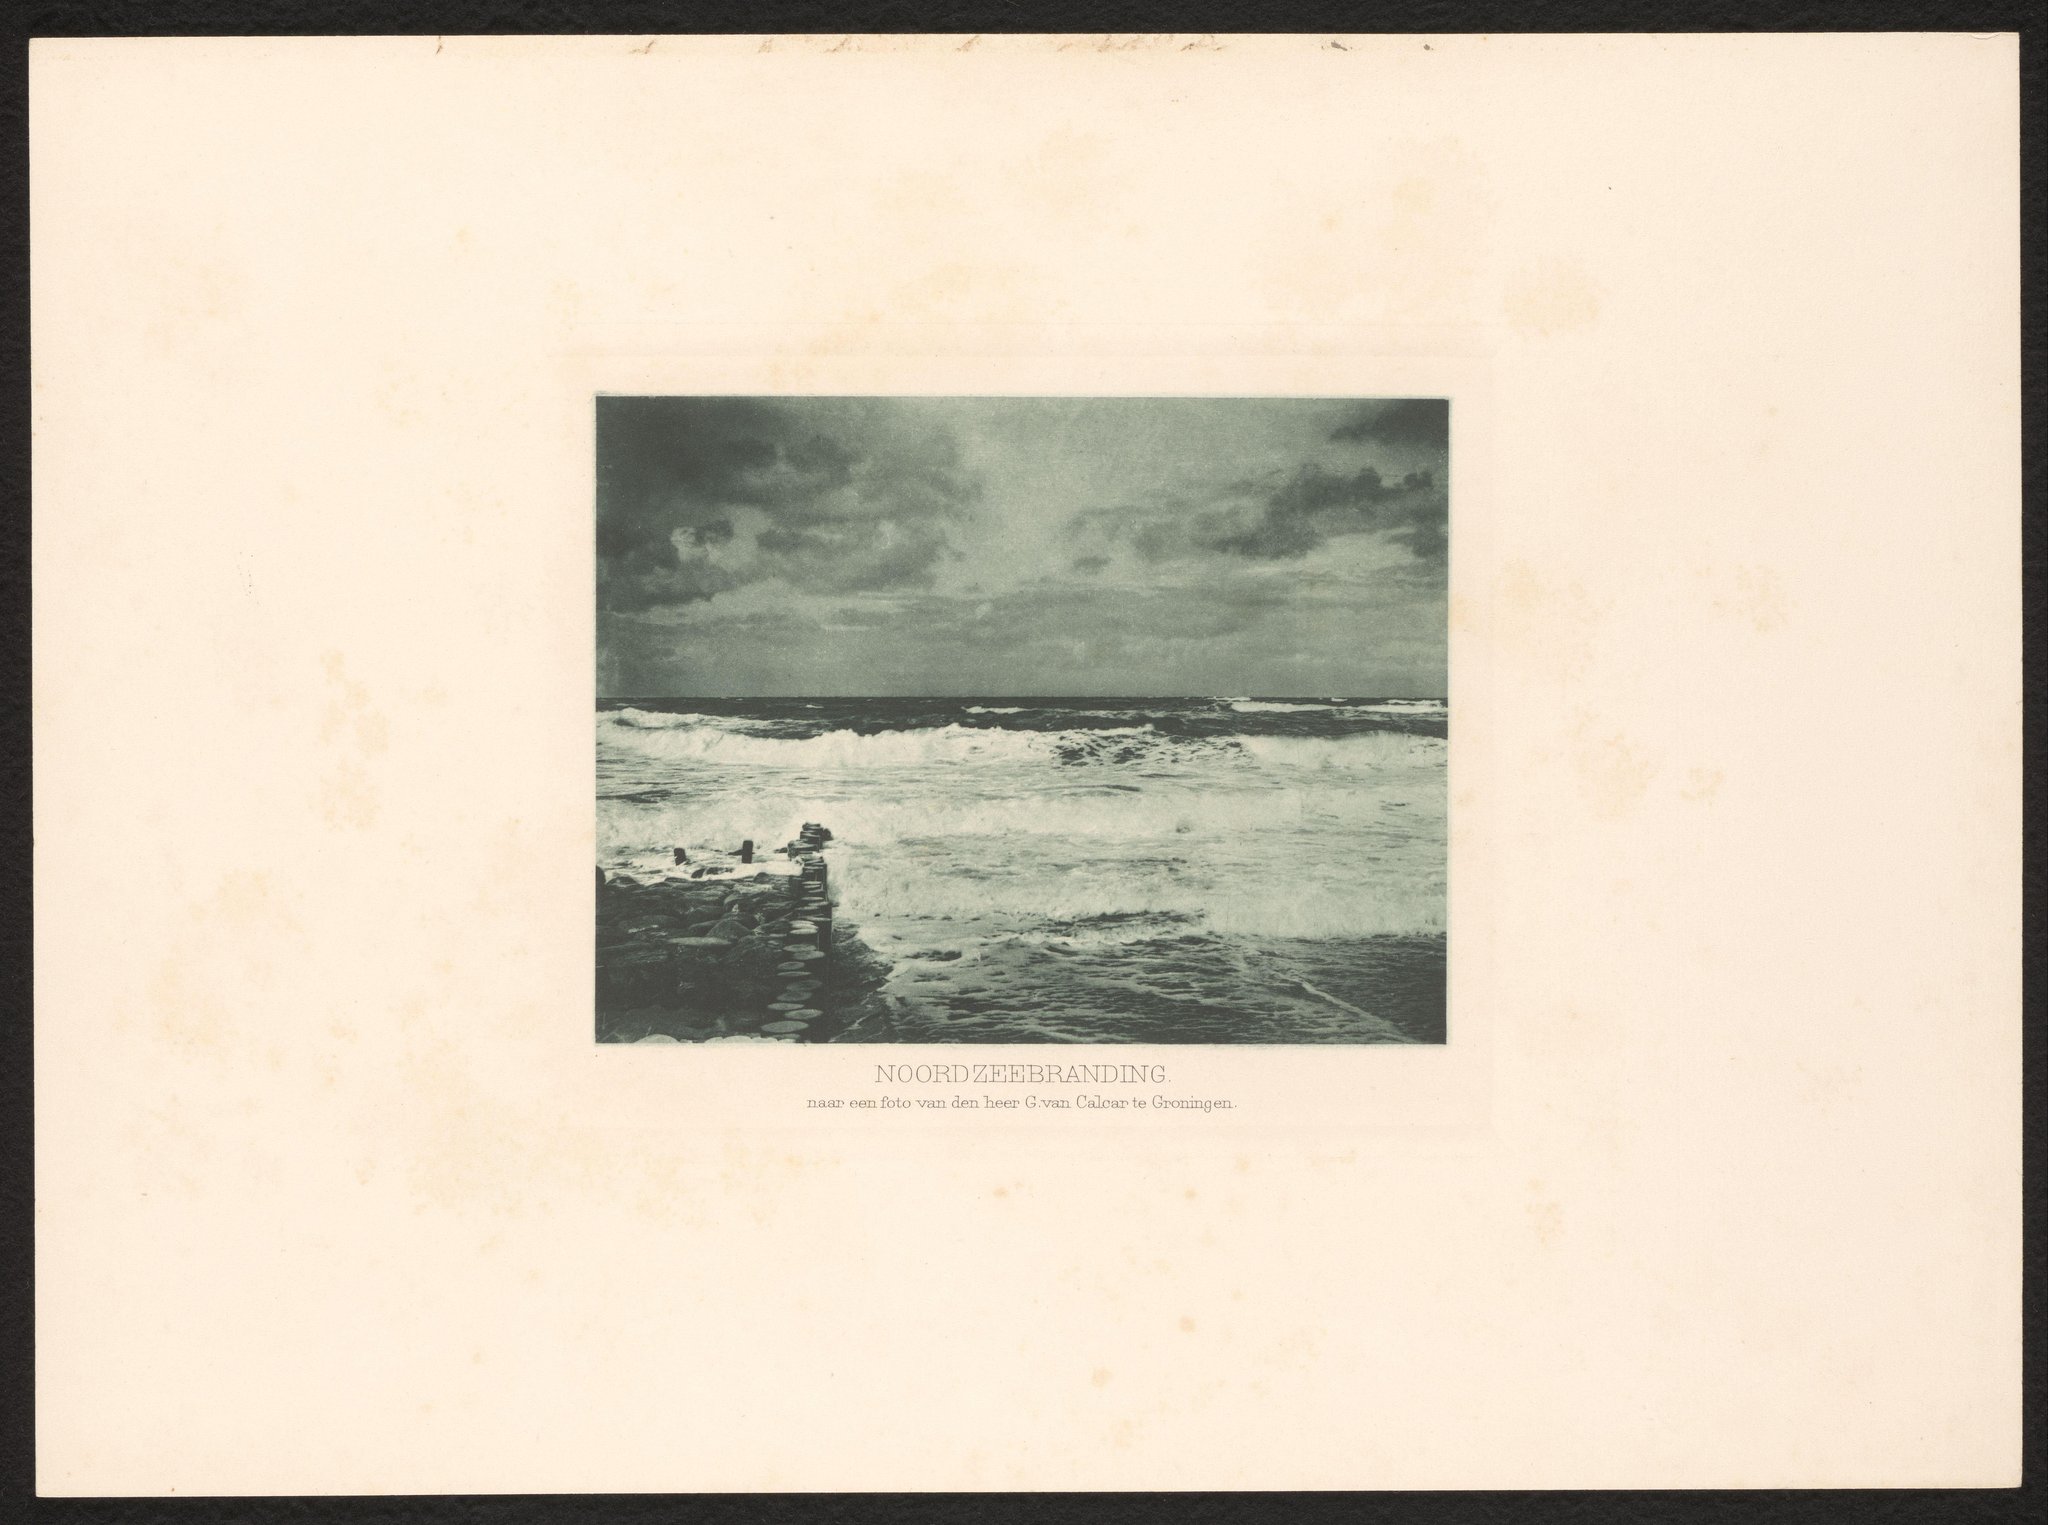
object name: photomechanical print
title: Gezicht op de Noordzee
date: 1900-1905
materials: paper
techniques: photoaquatint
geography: north sea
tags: sea (seascape), surf, breakers, coast, sea